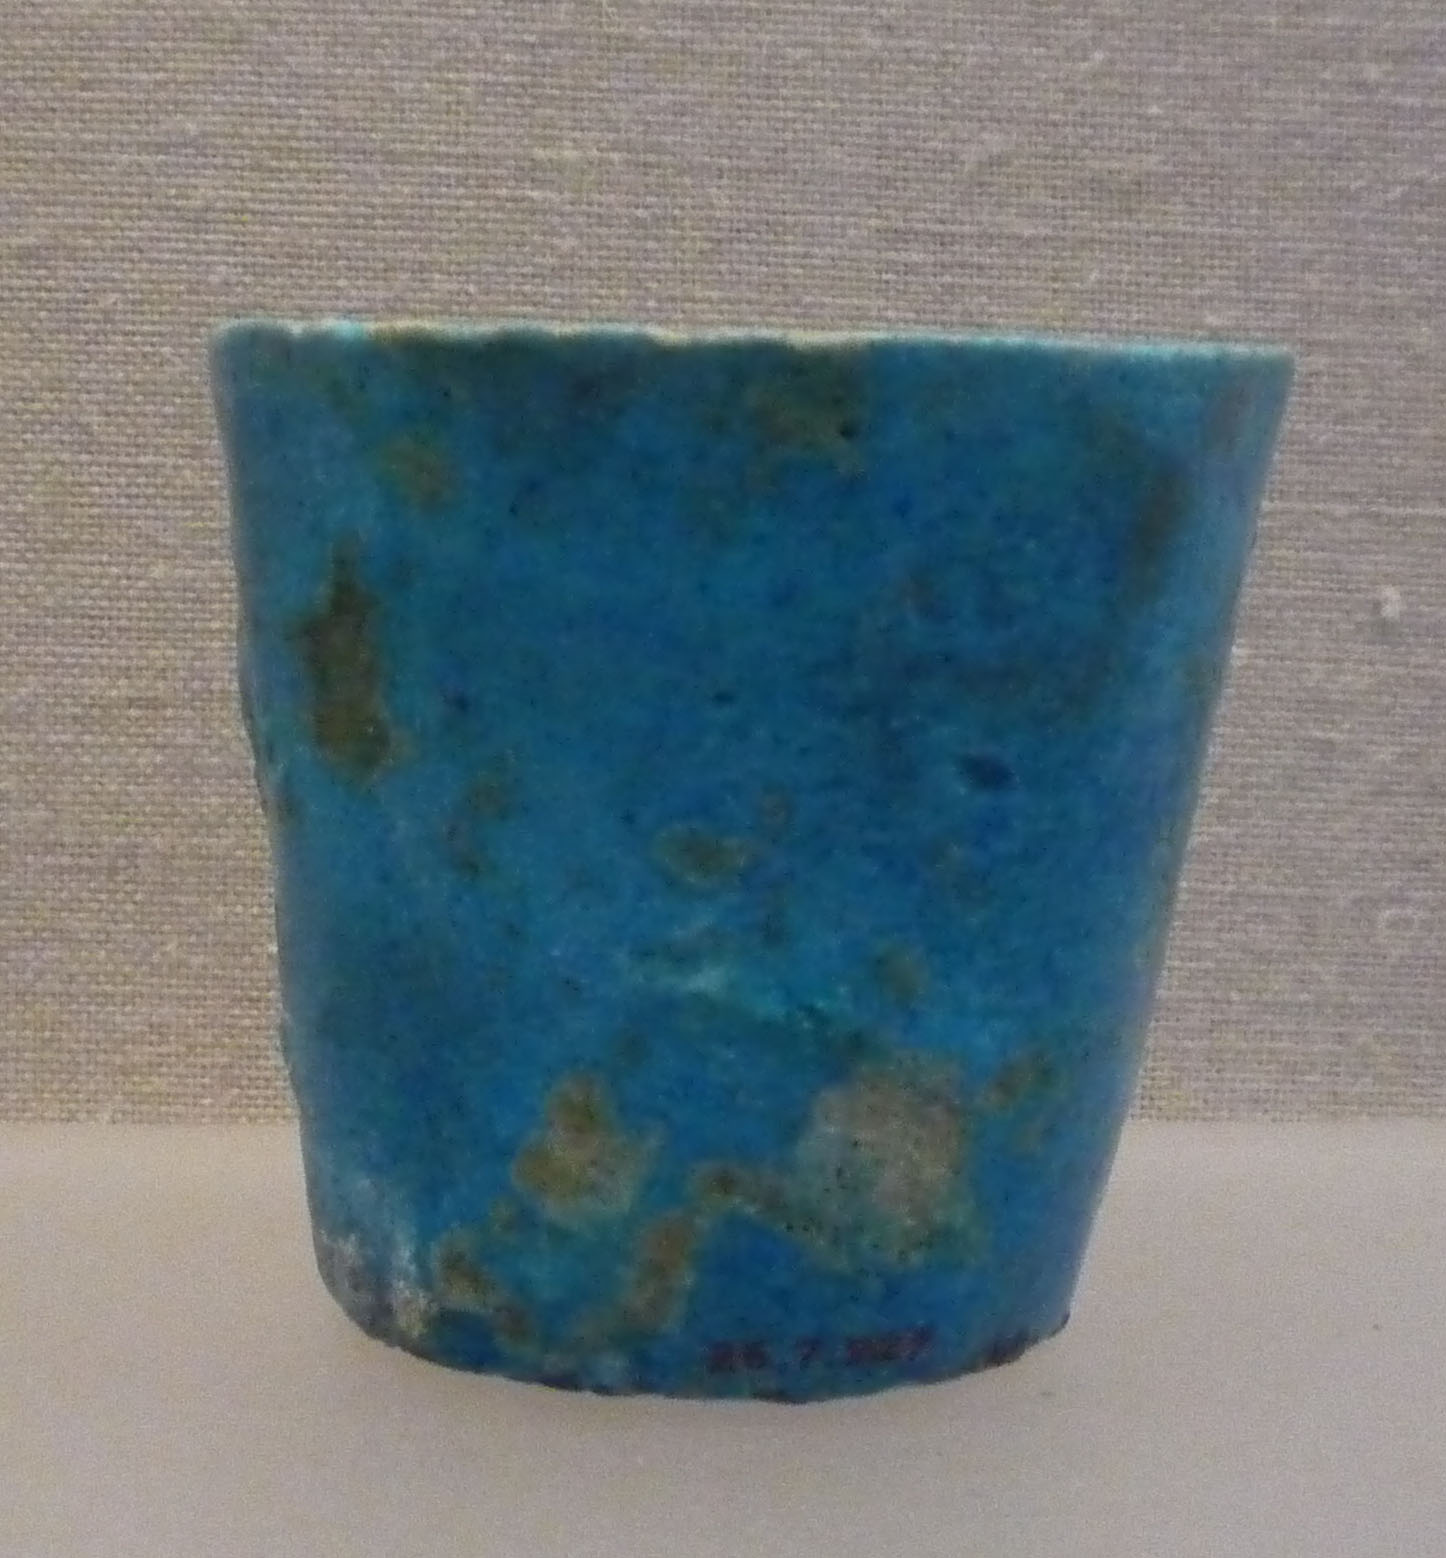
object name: cup, foundation deposit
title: Cup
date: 1479-1458 BCE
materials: faience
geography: egypt